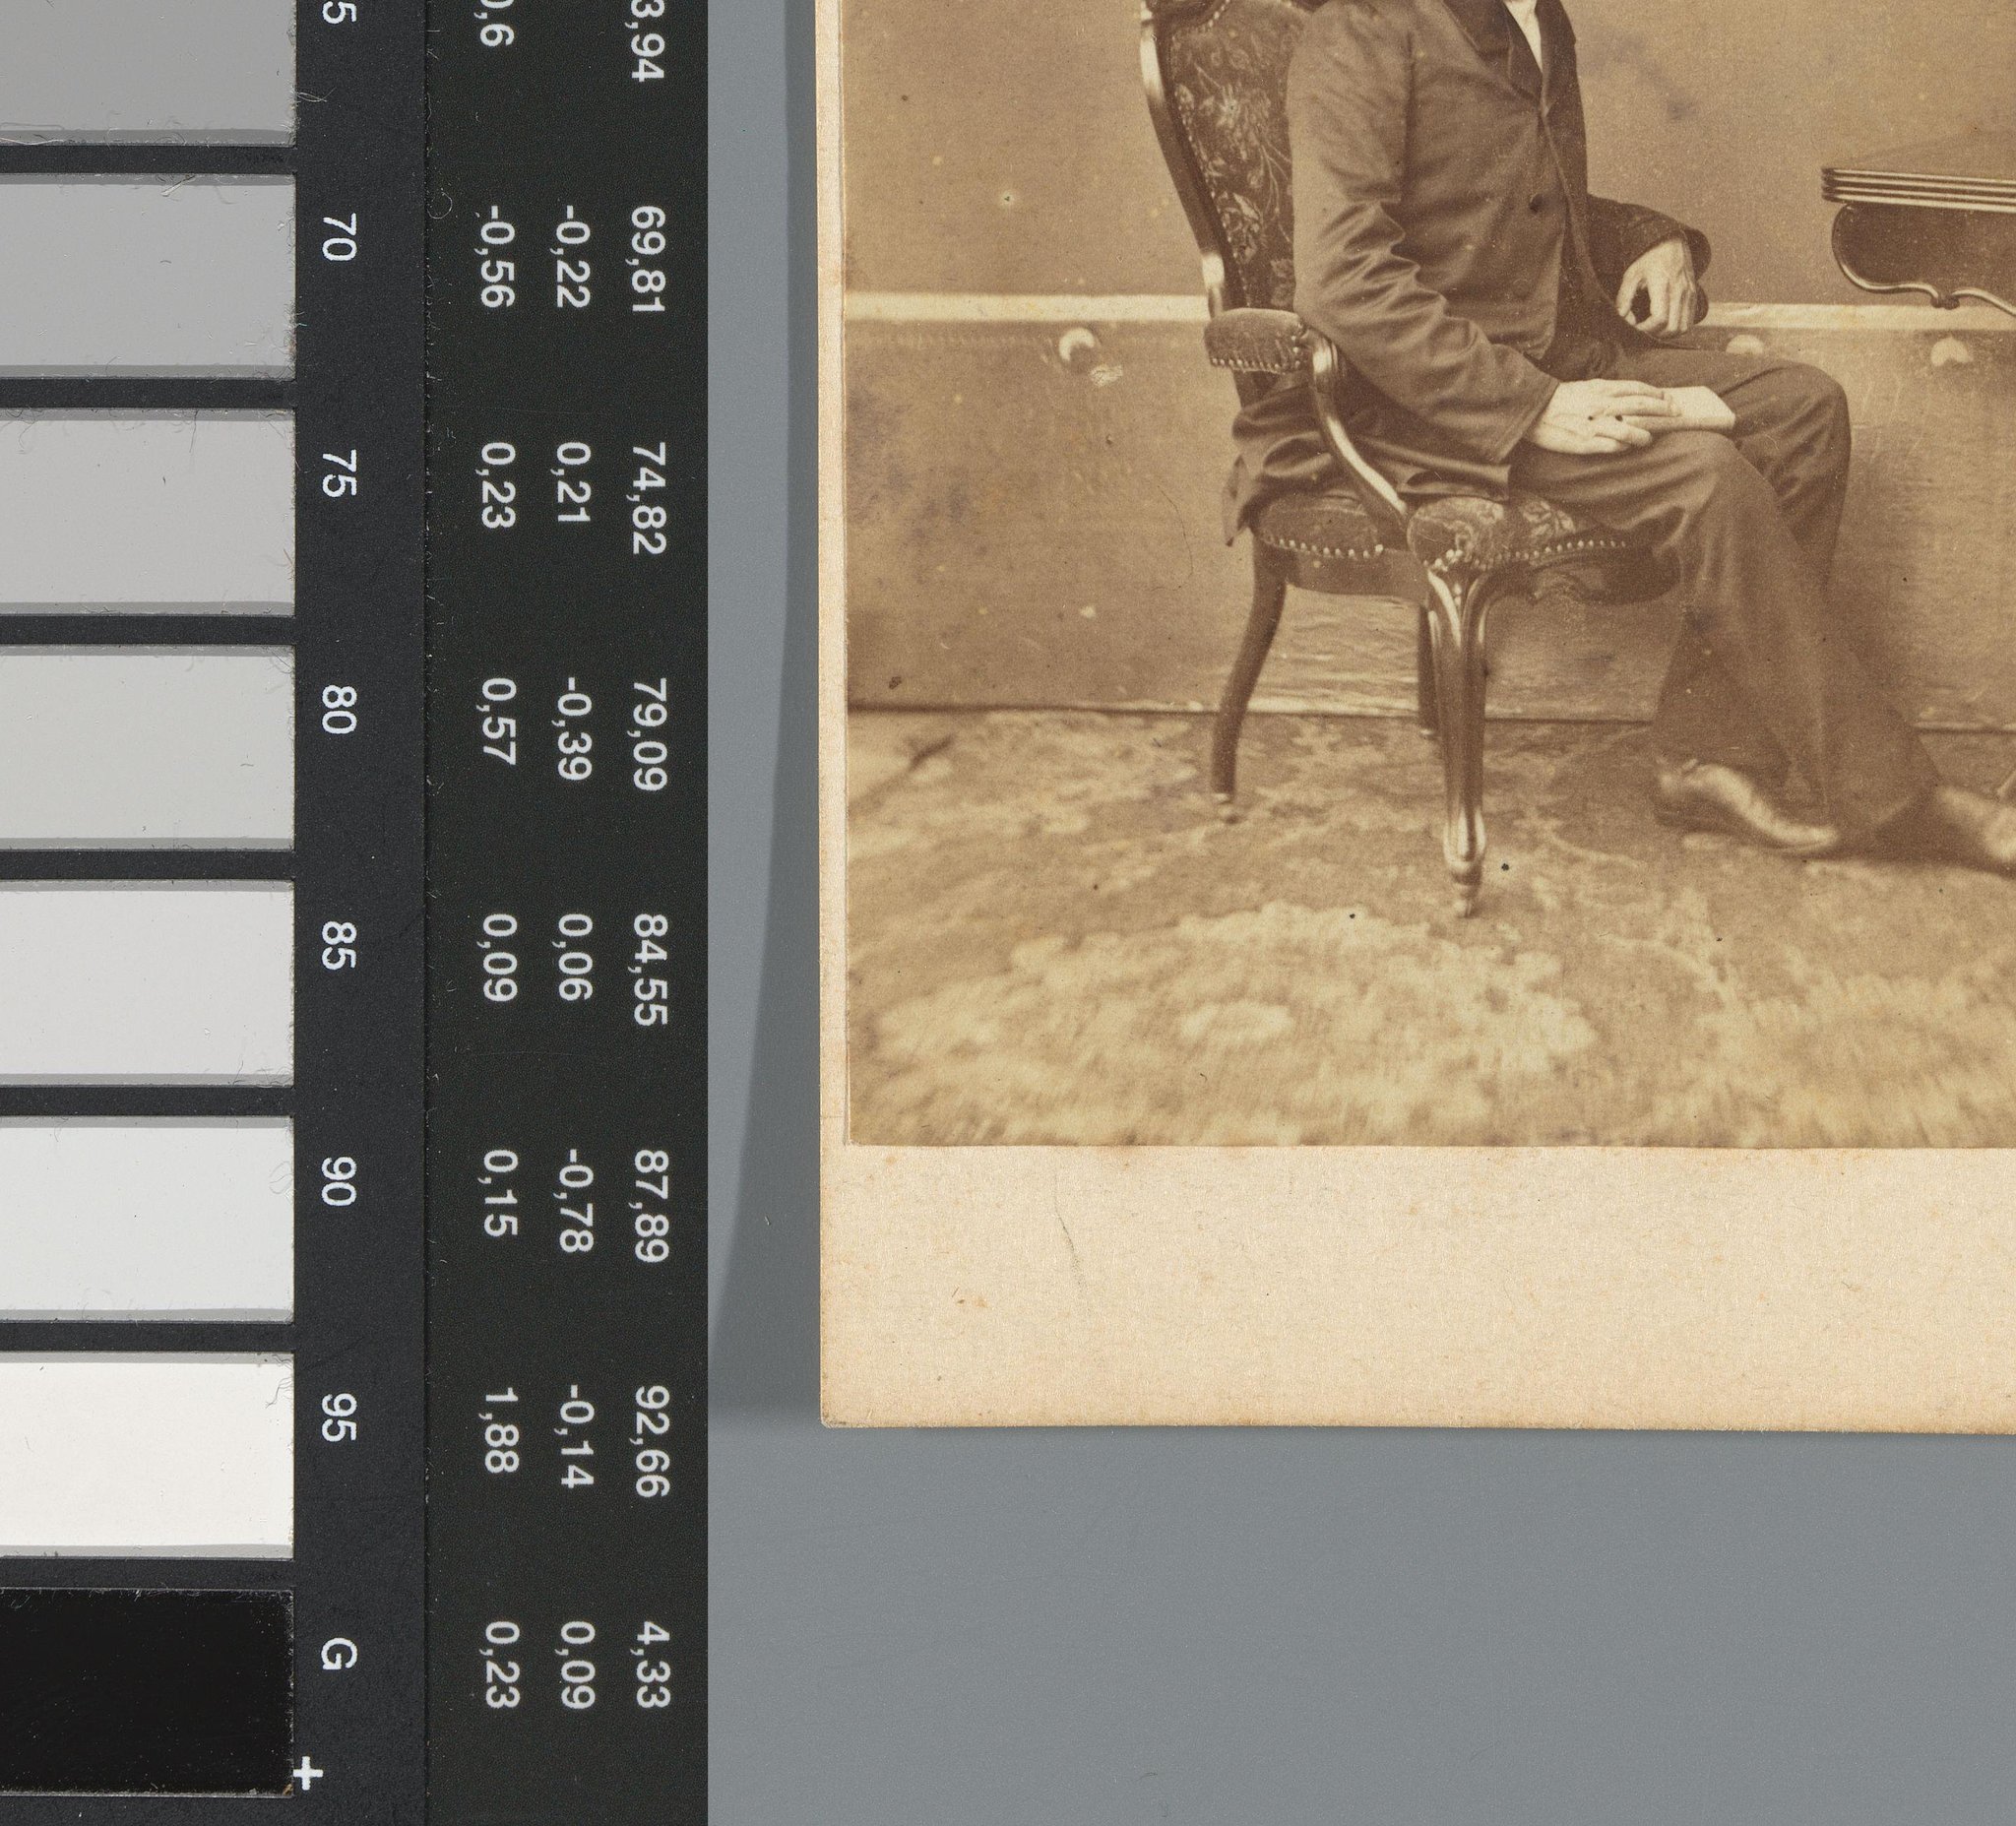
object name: photograph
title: Portret van Franciscus Johannes van den Berg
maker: Anonymous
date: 1855-1910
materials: cardboard, photographic support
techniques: albumen print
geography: netherlands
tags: rotterdam